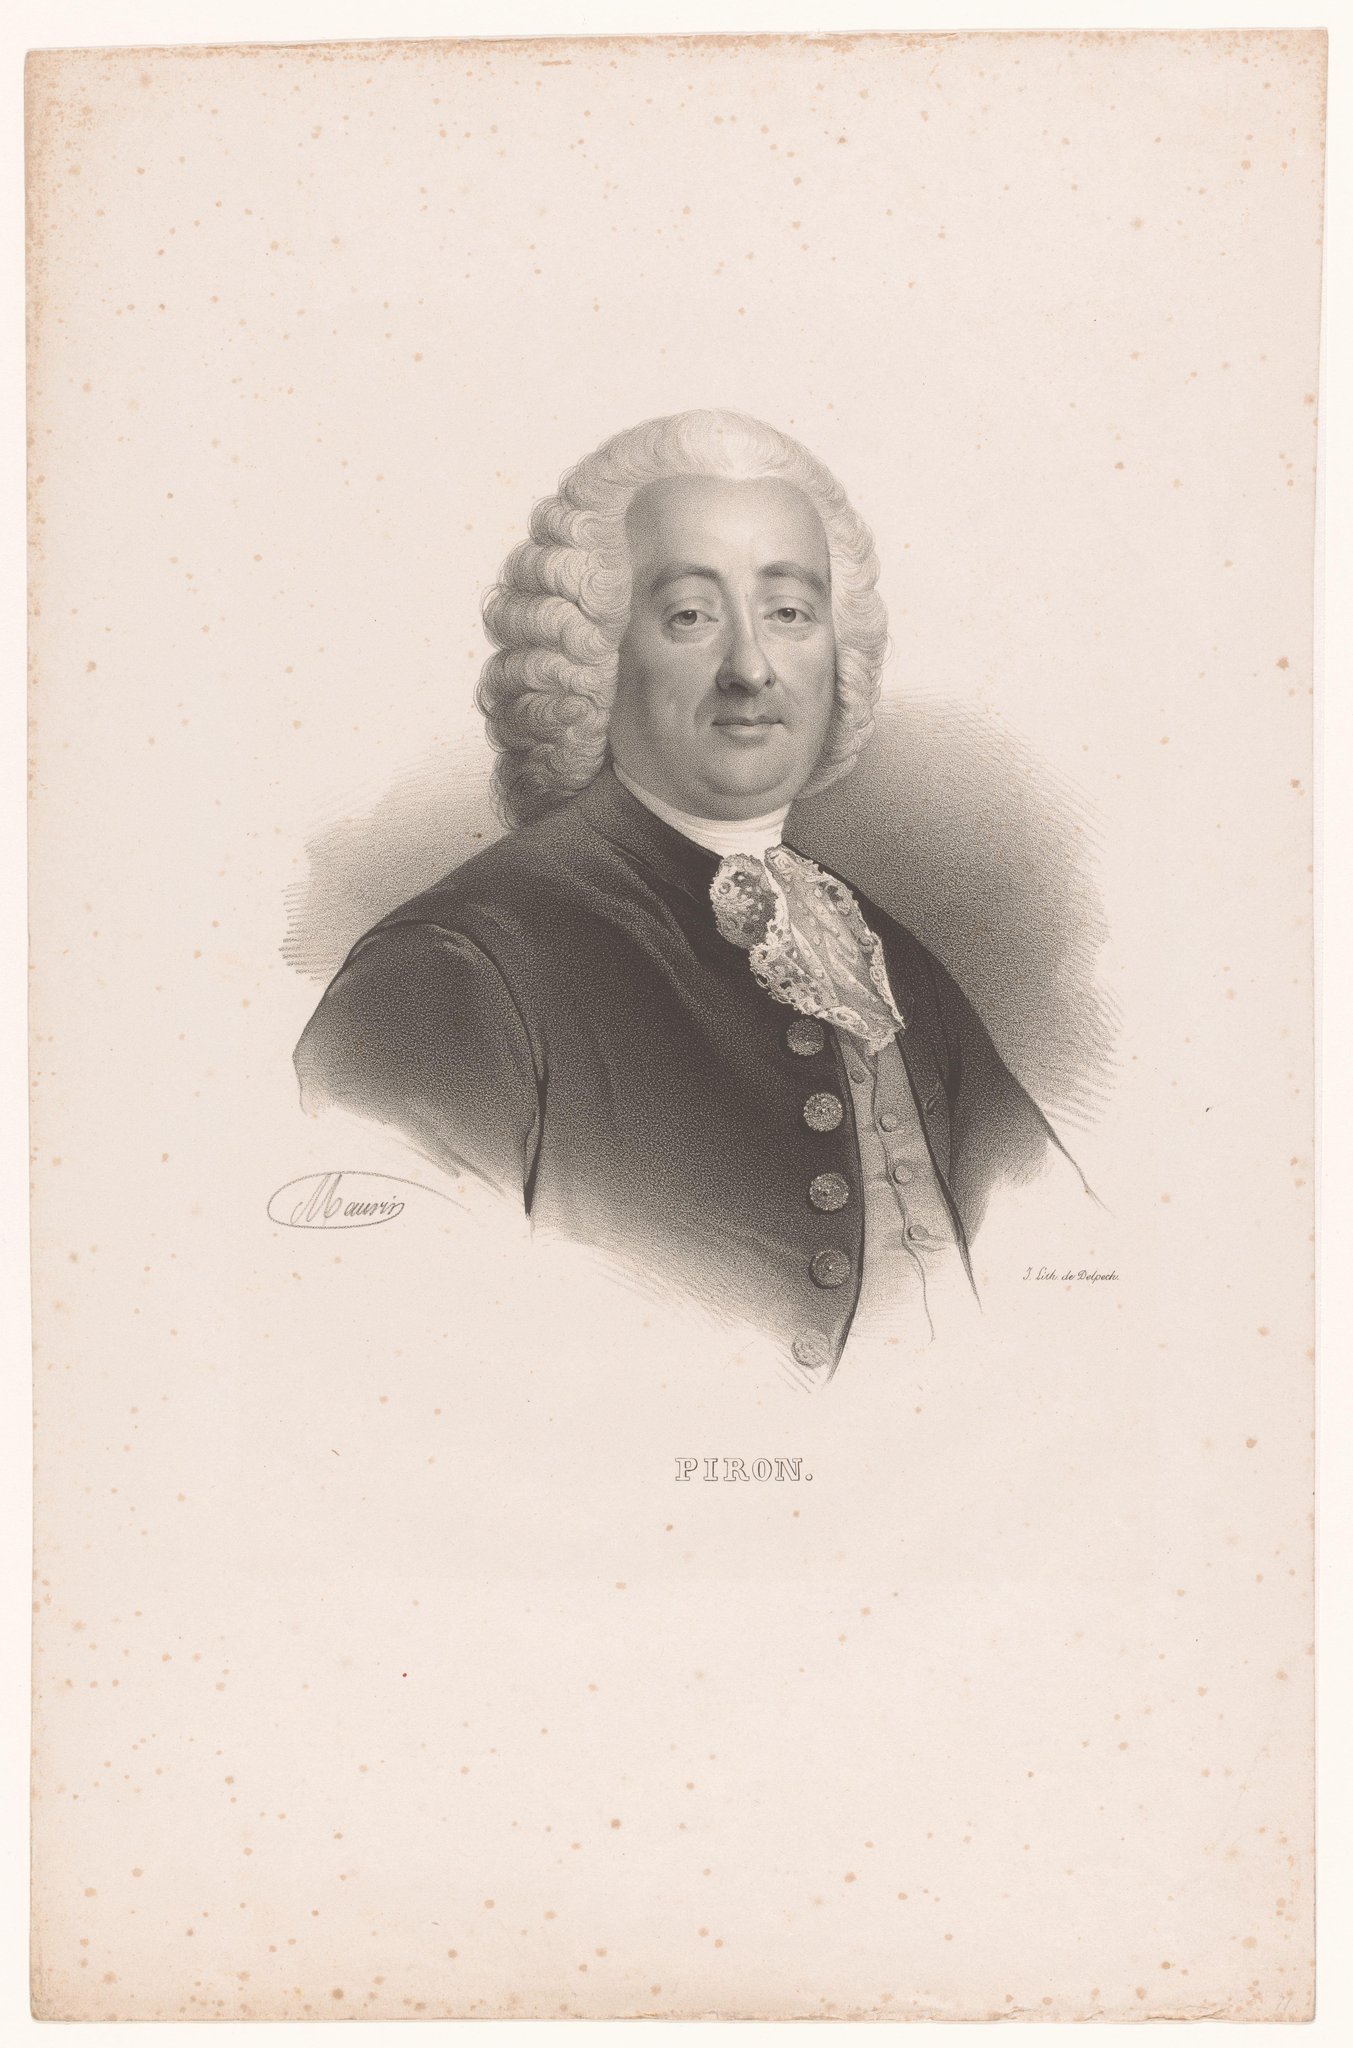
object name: print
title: Piron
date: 1825-1842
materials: paper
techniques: lithograph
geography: paris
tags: historical persons, writer, poet, author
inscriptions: collector's mark: Lugt 2228